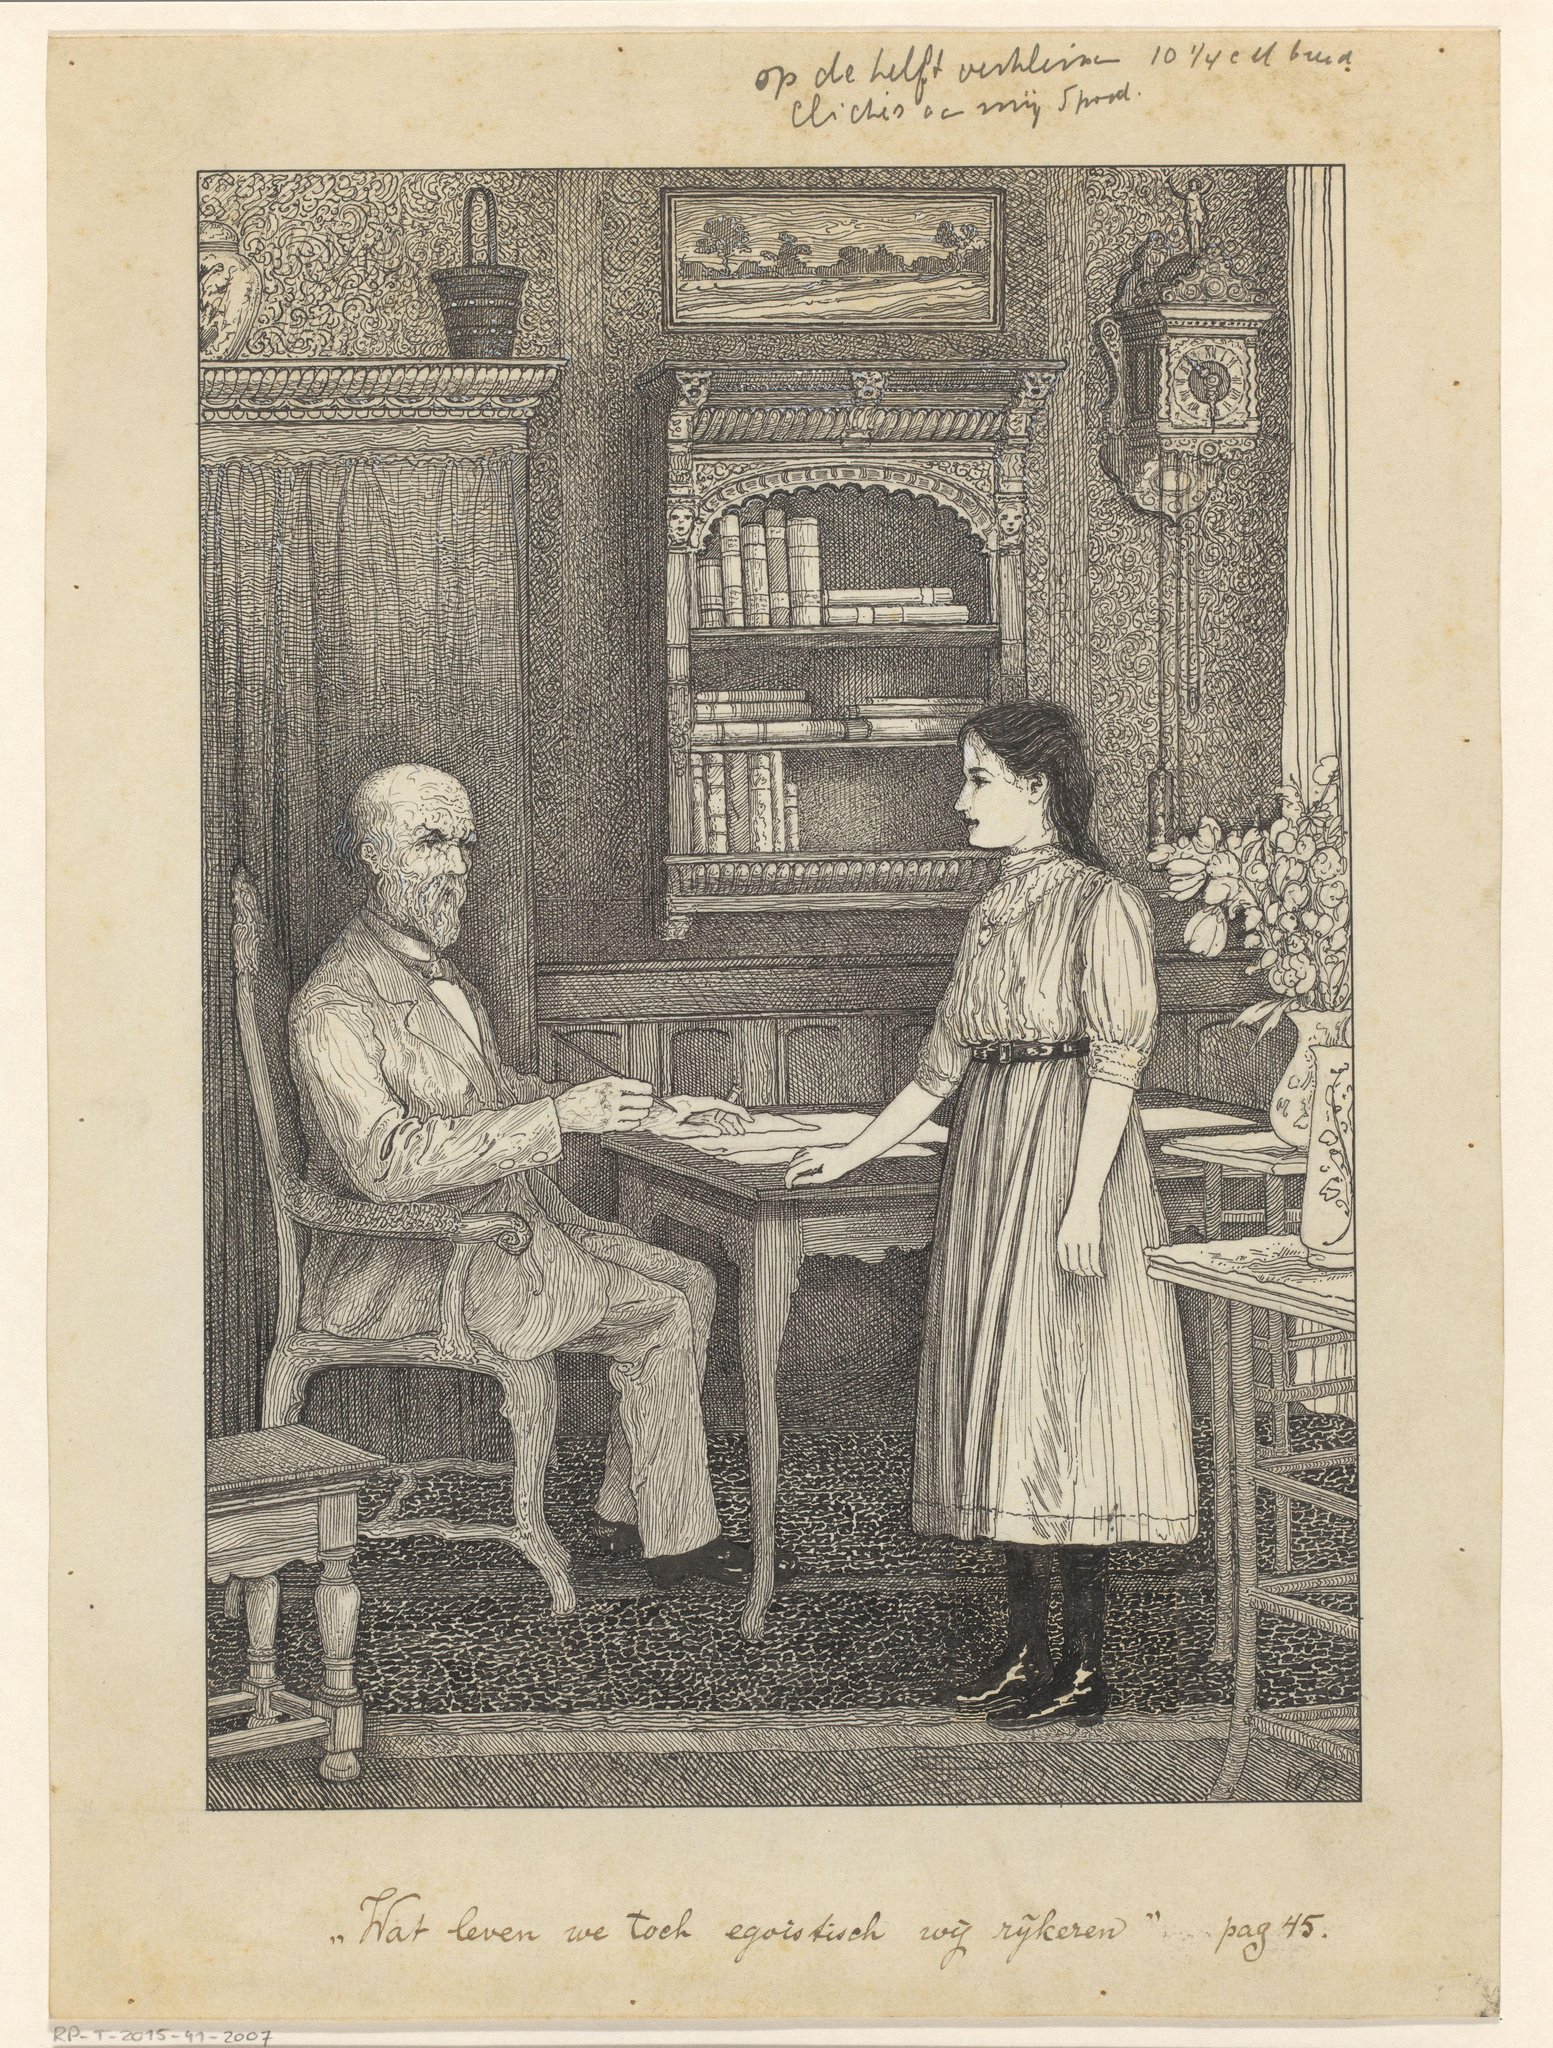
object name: boekillustratie ontwerp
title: Meisje en schrijvende man bij een tafel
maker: willem pothast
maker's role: draughtsman, print maker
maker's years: 1877-1916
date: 1887-1916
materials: paint, ink, paper, pencil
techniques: brush, pen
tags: adolescent, young woman, maiden, writing accessories, sitting figure (+ old male (human being))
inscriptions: annotation: ‘"Wat leven we toch egoistisch wij rijkeren" pag 45.’, collector's mark: Lugt 2228, :, signature: ‘W.P.’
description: In een interieur, mogelijk een studeerkamer, zit een oude man aan een tafel met een pen in de hand. Voor hem liggen vellen papier. Een meisje staat bij de tafel en leunt erop met haar hand. In de achtergrond een boekenkast.